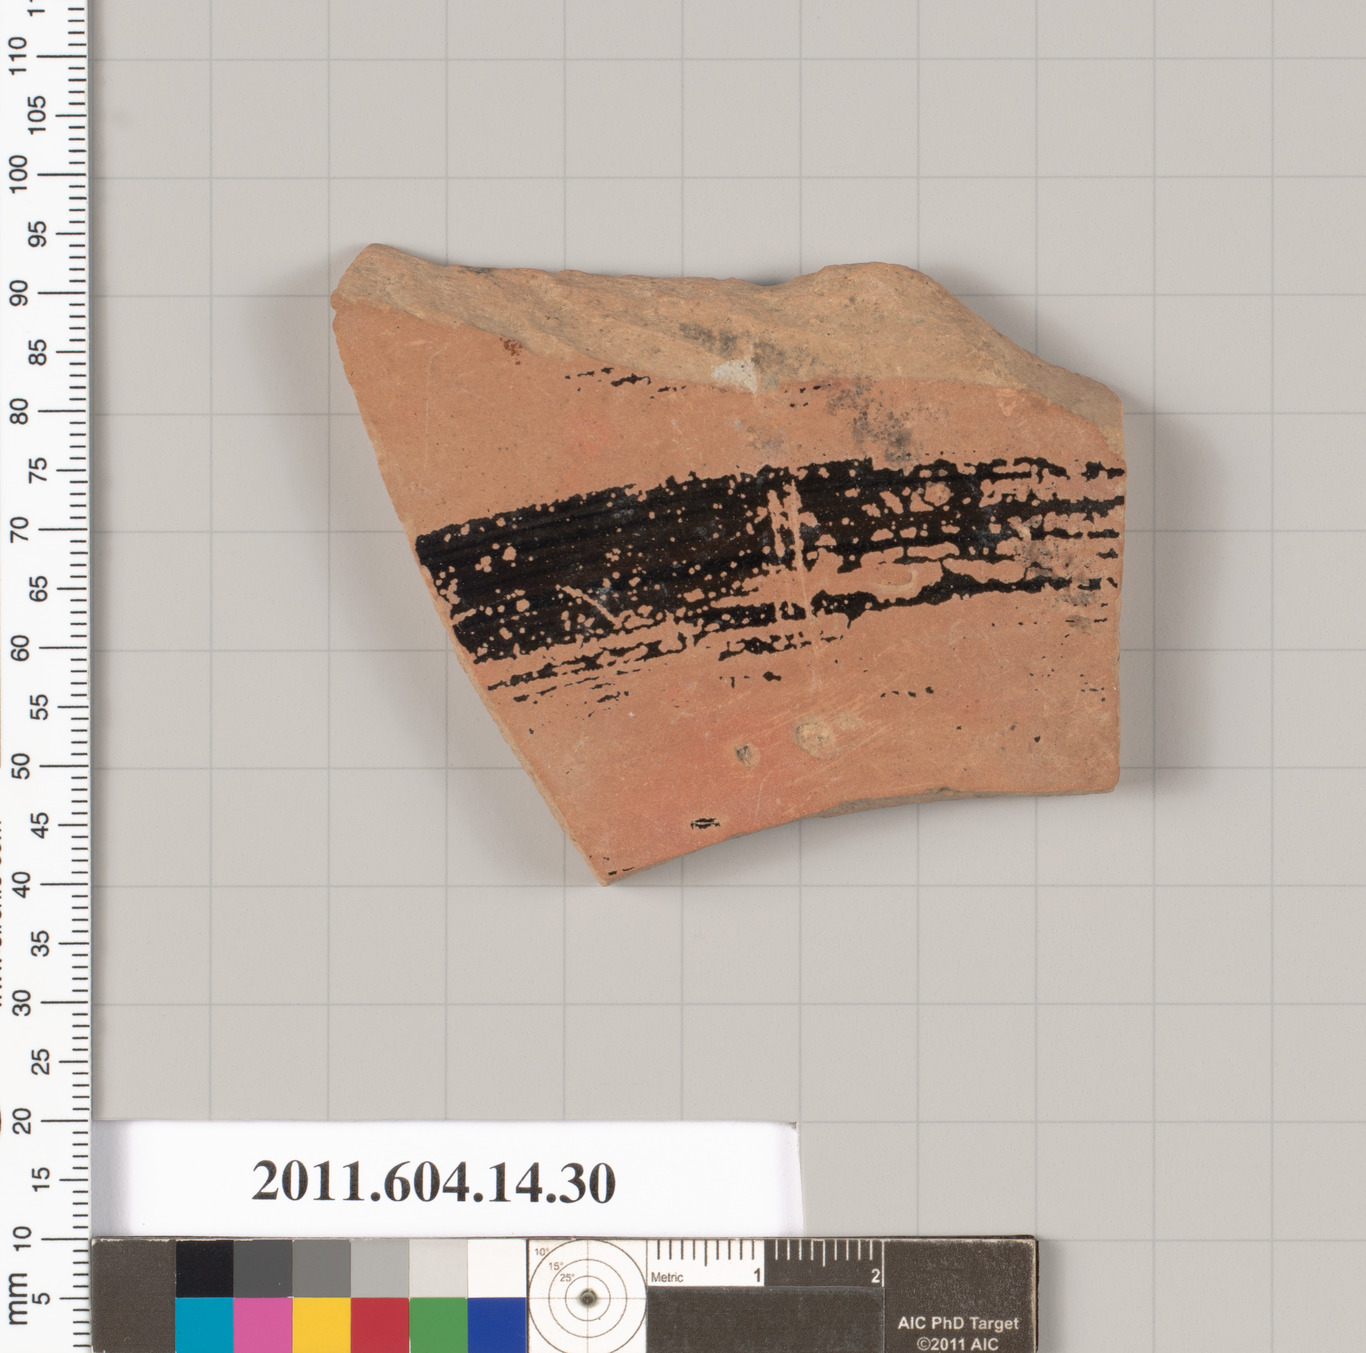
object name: undetermined closed shape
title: Terracotta fragment of an undetermined closed shape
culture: unknown fabric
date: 600-401 BCE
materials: terracotta